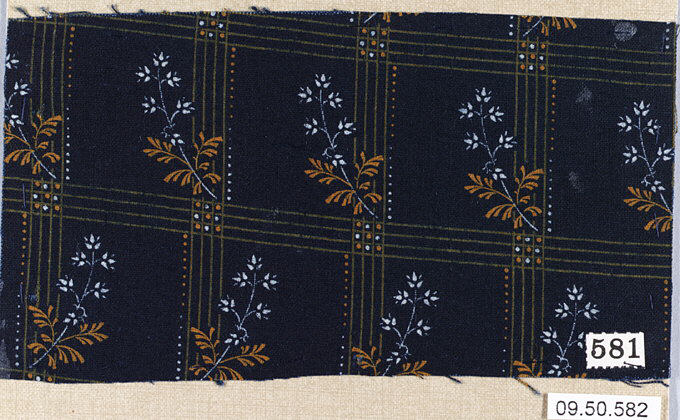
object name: piece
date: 1801-1900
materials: cotton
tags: flowers,leaves